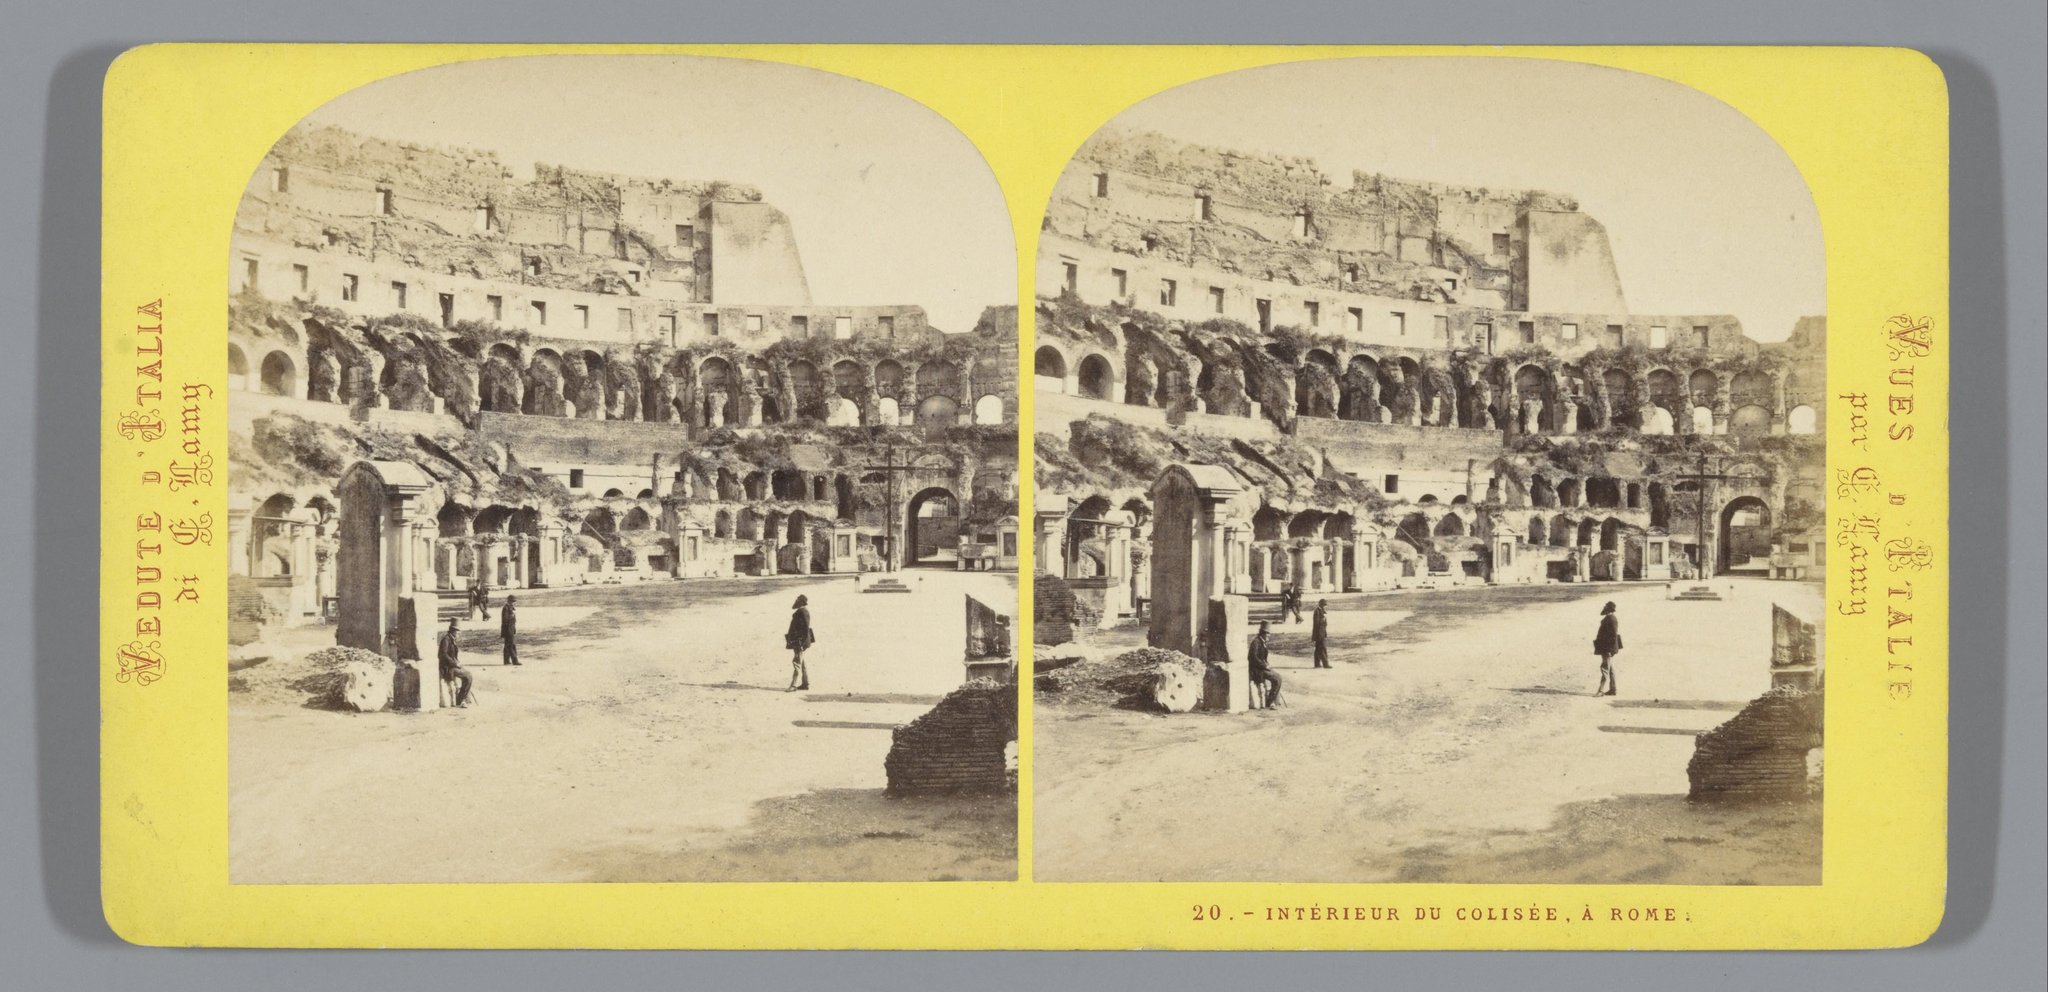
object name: stereograph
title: Intérieur du Colisée, à Rome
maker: ernest eléonor pierre lamy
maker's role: publisher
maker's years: 1828-1900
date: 1861-1878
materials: cardboard, paper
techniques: albumen print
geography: rome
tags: amphitheatre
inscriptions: number: ‘20.’